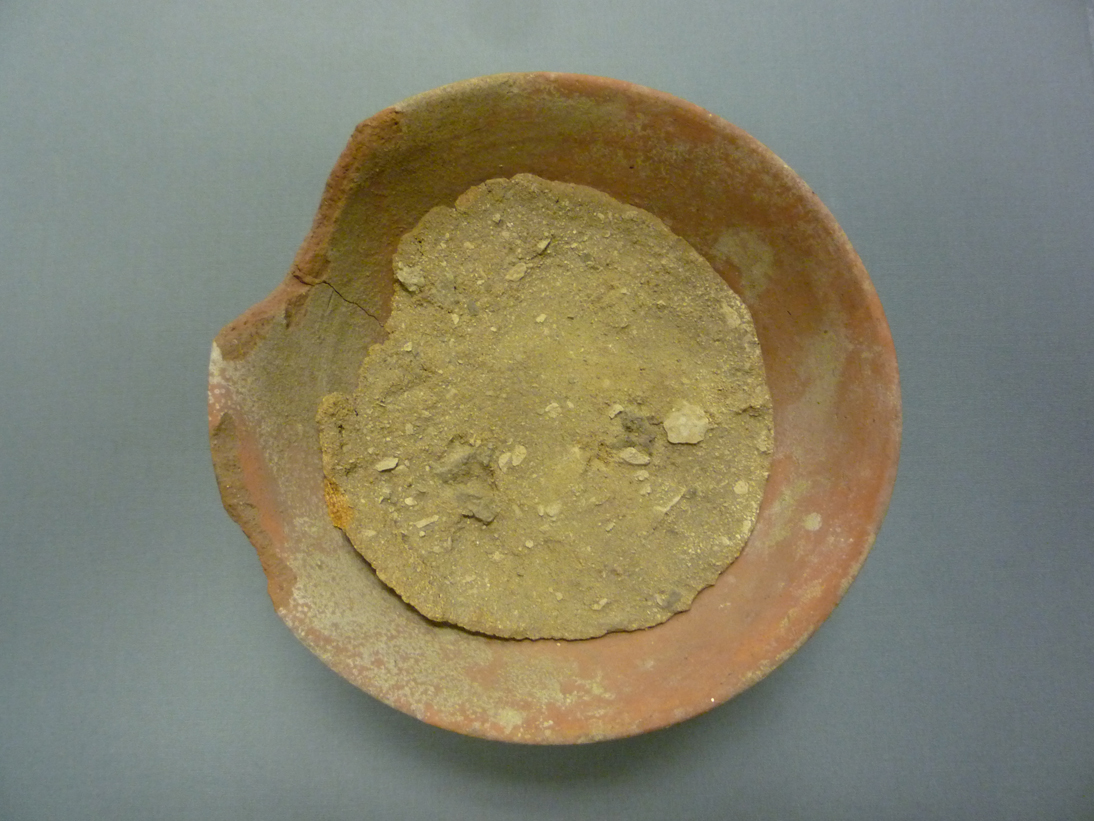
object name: bowl, fig, foundation deposit, hatshepsut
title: Bowl of Fat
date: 1479-1458 BCE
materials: pottery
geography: egypt